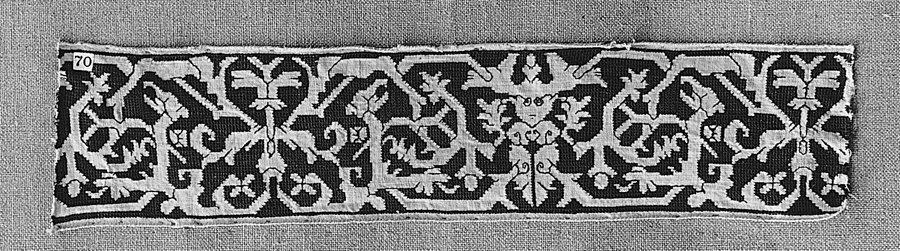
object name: band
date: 1501-1700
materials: linen, silk